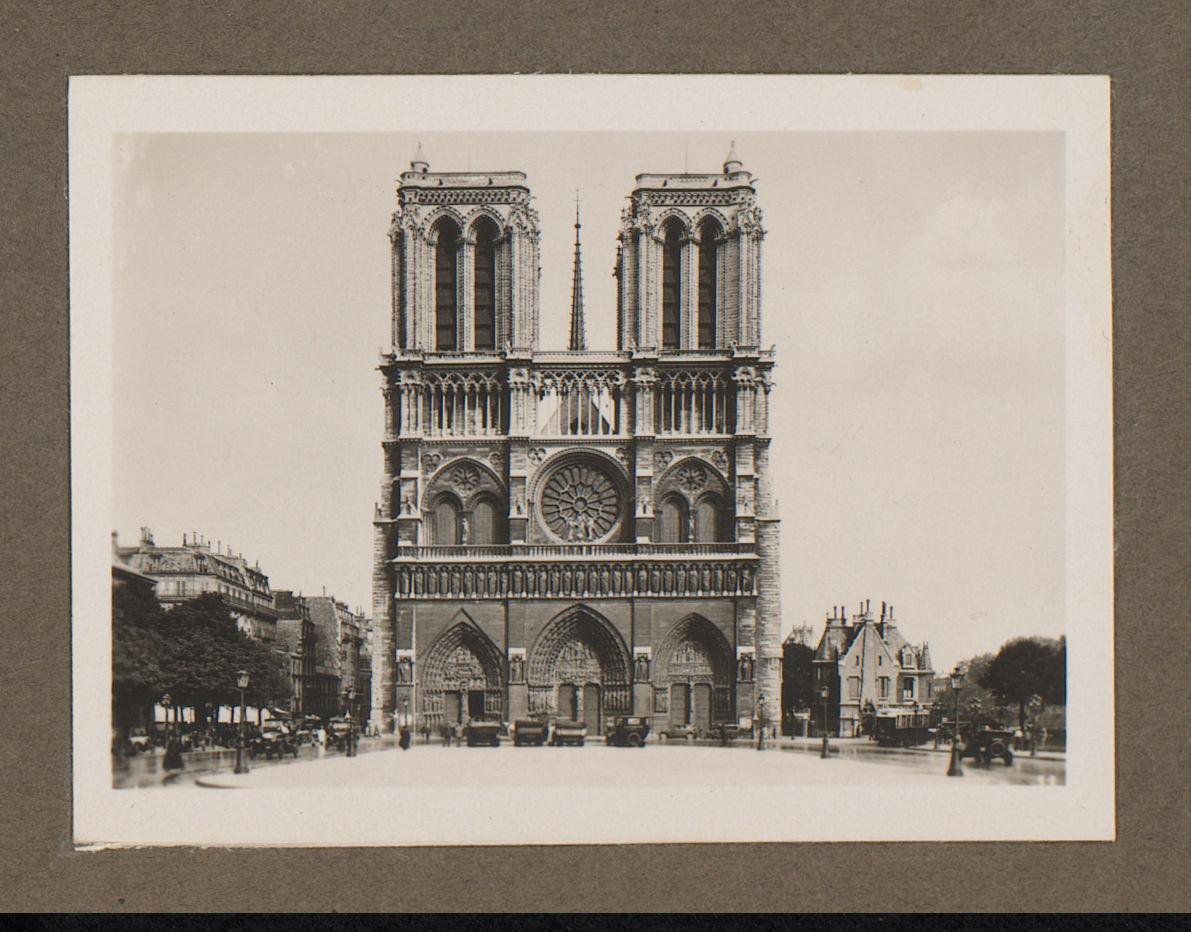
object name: photograph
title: Façade van de Notre-Dame, Parijs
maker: Anonymous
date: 1928-1933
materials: paper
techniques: gelatin silver print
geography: paris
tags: parts of church exterior and annexes: façade